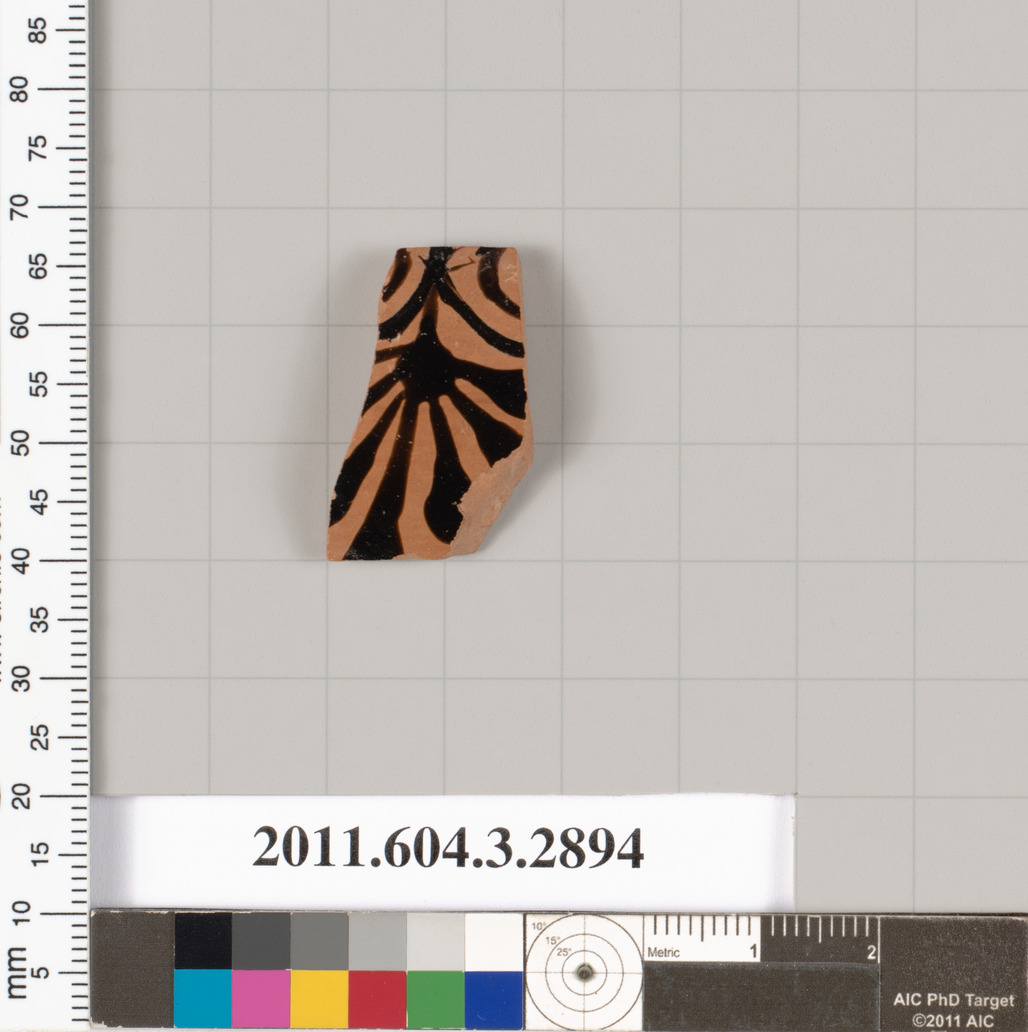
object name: lekythos fragment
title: Terracotta fragment of a lekythos (oil flask)?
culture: greek, attic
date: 534-468 BCE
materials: terracotta